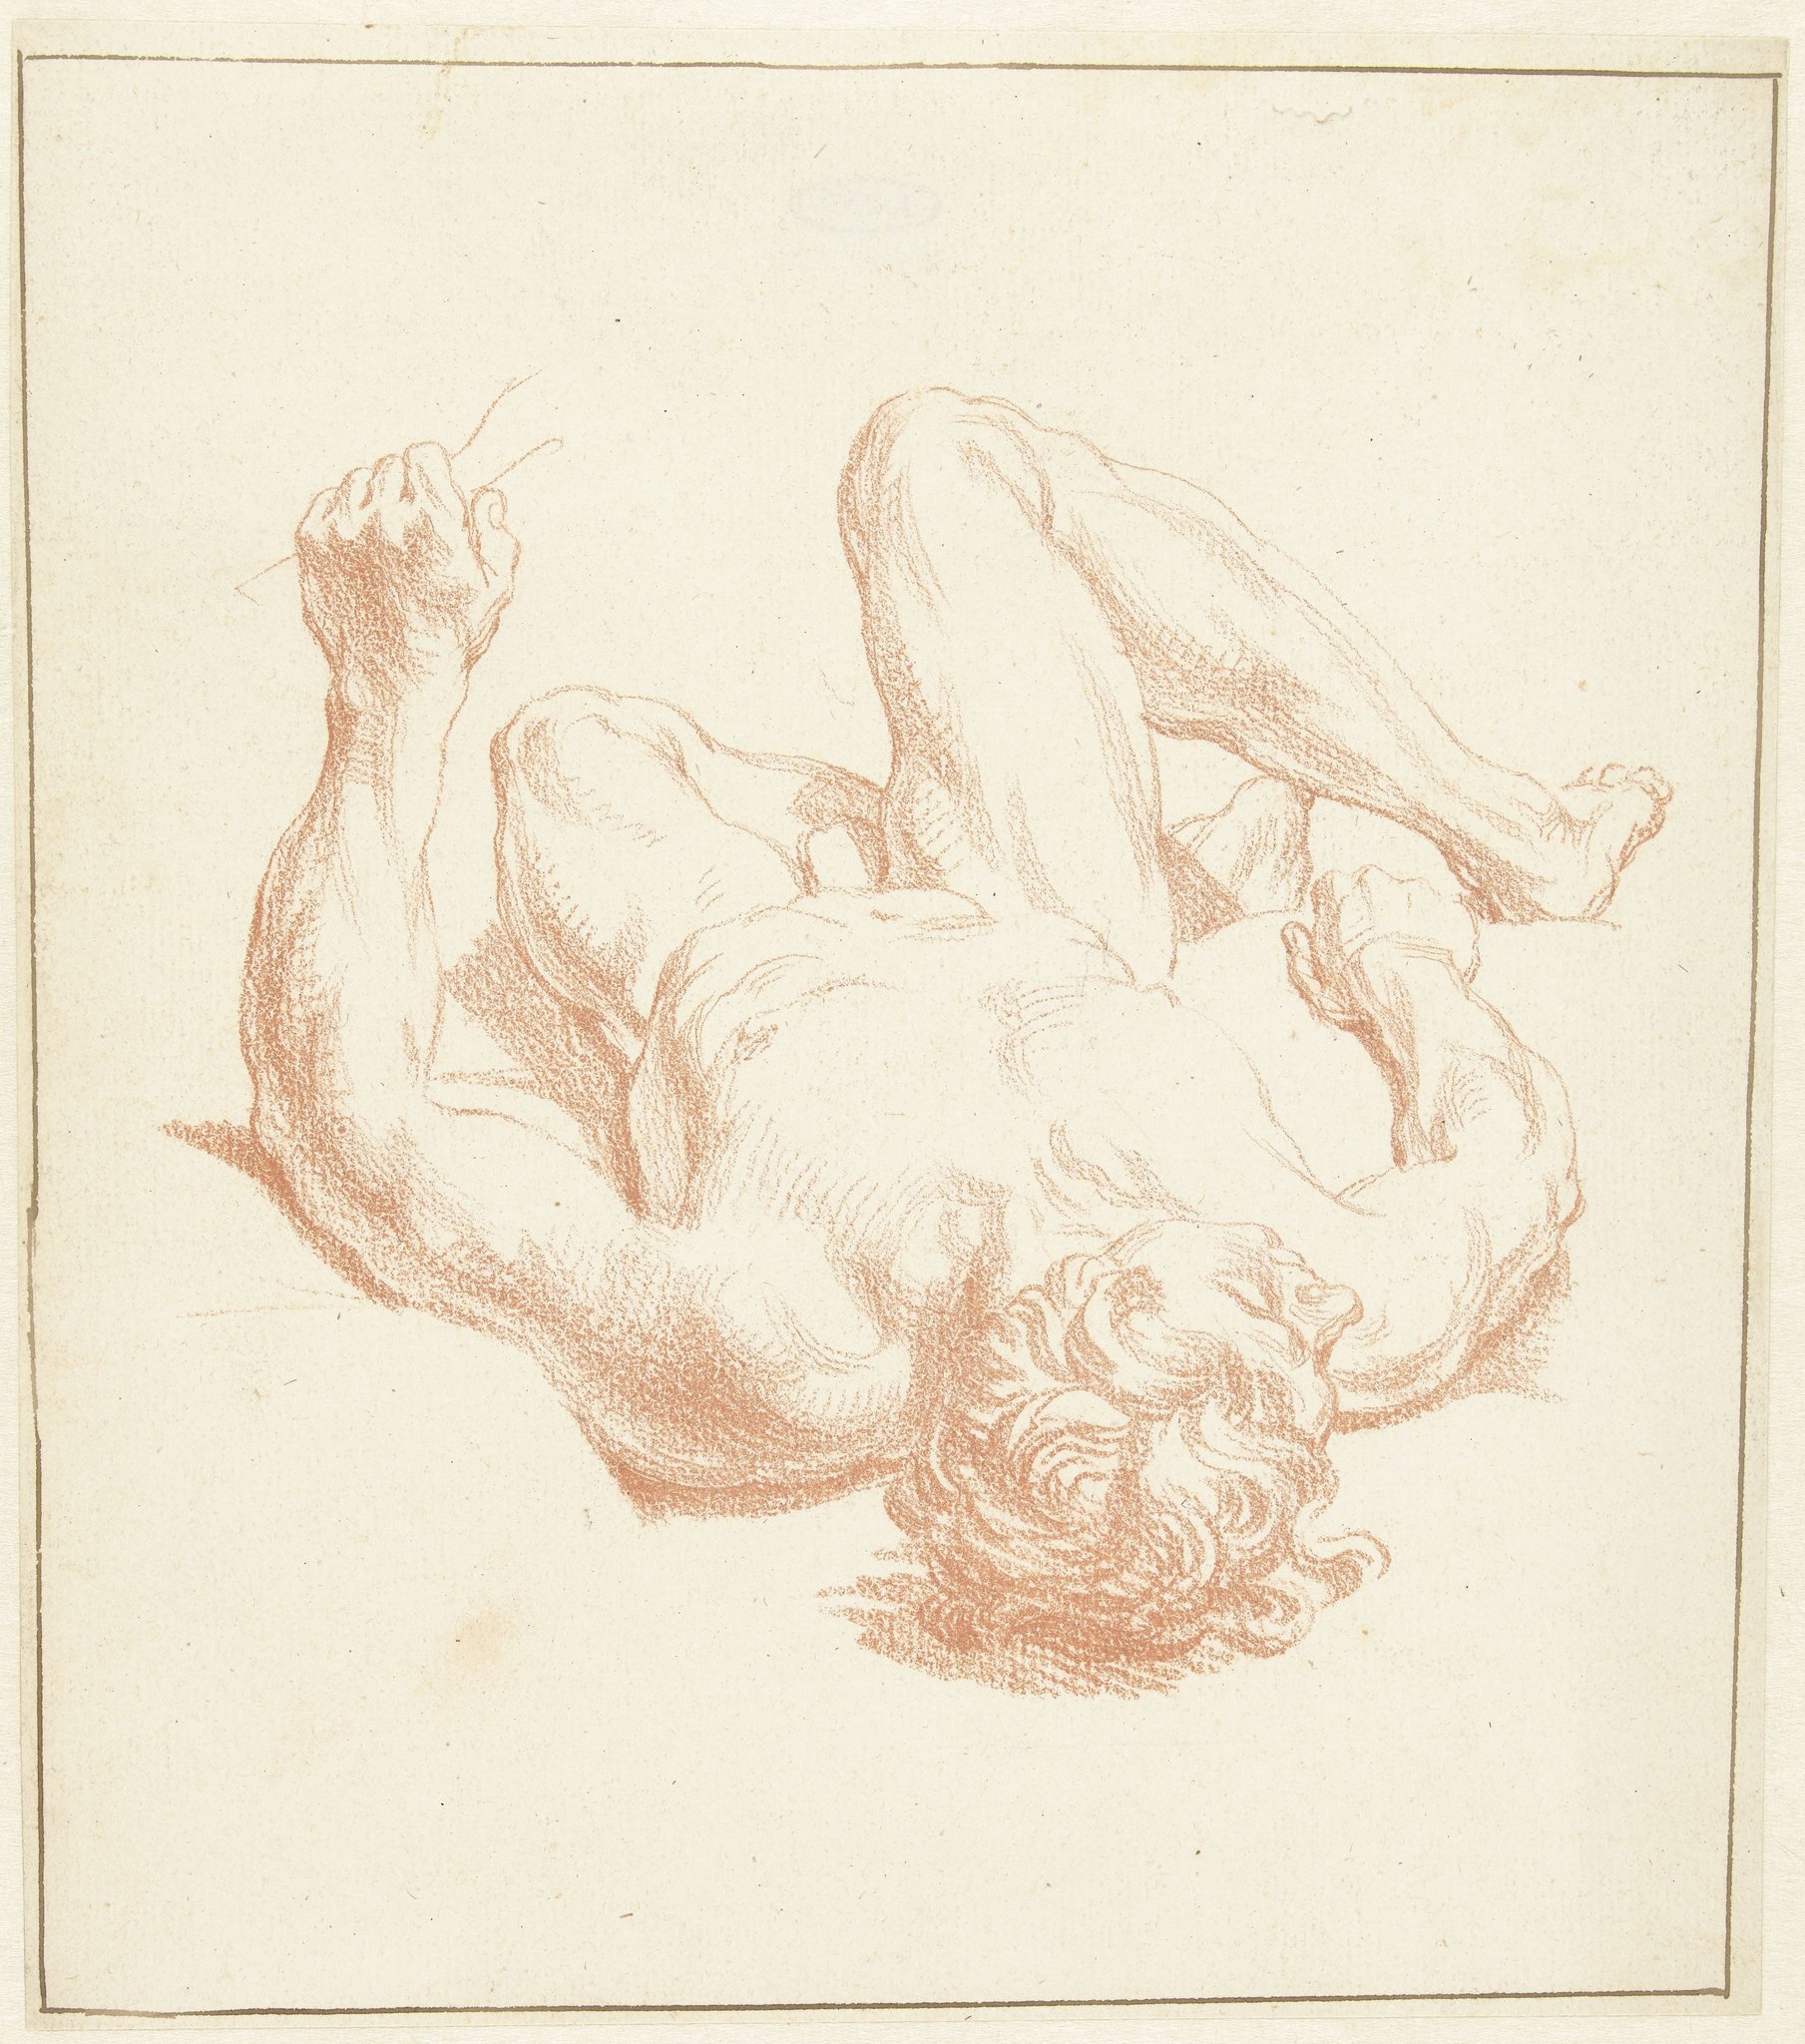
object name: drawing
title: Studie van mannelijk naakt, liggend op de rug, in het verkort weergegeven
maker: louis fabritius dubourg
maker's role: draughtsman, print maker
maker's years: 1693-1775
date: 1703-1775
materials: chalk, paper